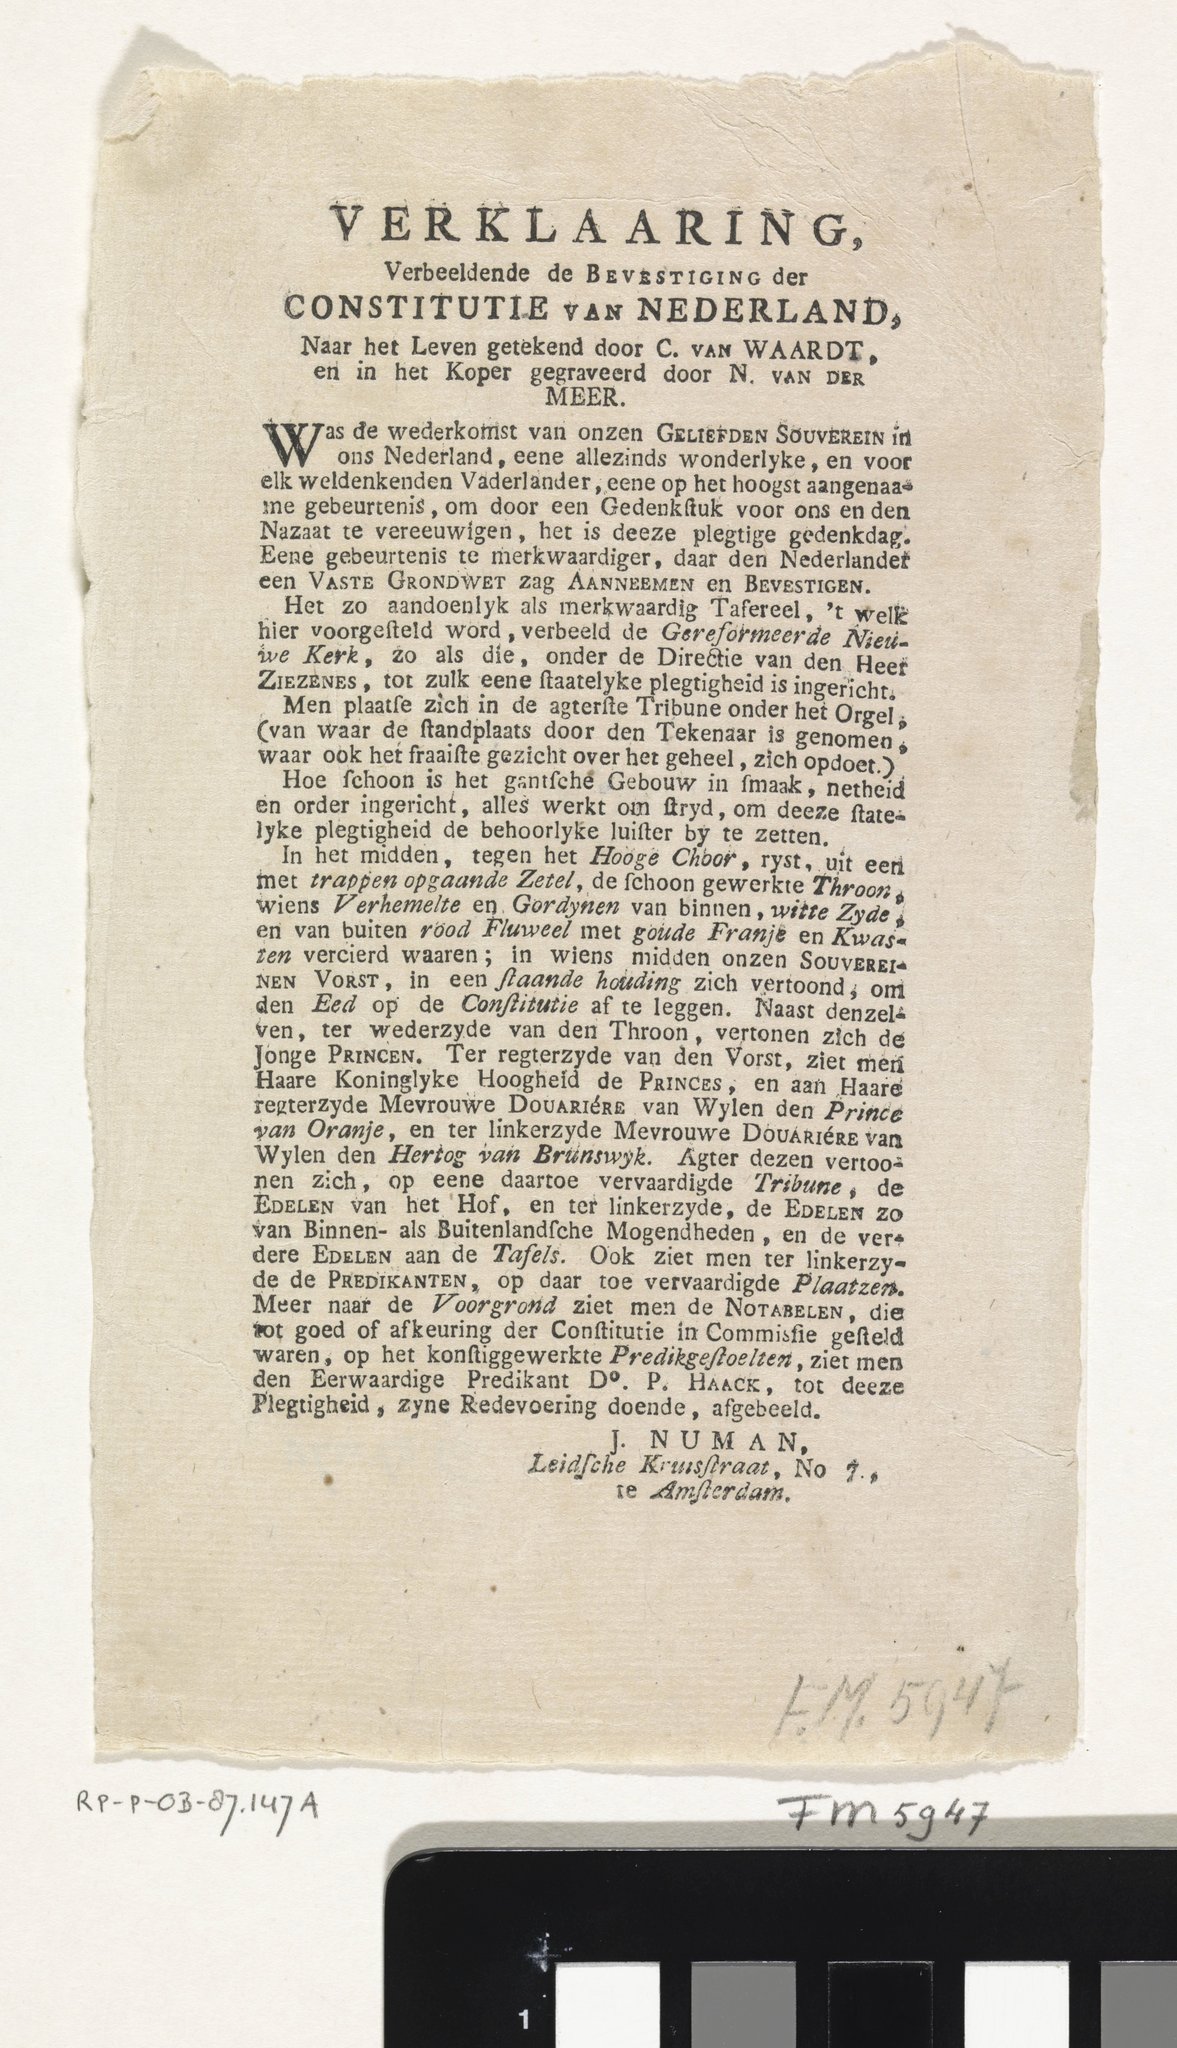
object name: text sheet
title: Verklaring bij de prent met de inhuldiging van Willem Frederik, prins van Oranje als souverein vorst, 1814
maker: j. numan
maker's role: publisher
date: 1814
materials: paper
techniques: letterpress printing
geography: amsterdam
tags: the hague, berlin, william i of the netherlands, brielle, petrus haack, ceremonial celebration of installation of a ruler, new ruler taking the oath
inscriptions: collector's mark: Lugt 2228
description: Tekstblad met een verklaring van de voorstelling van de prent met Willem Frederik, prins van Oranje ingehuldigd als soeverein vorst in de Nieuwe Kerk te Amsterdam op 30 maart 1814.